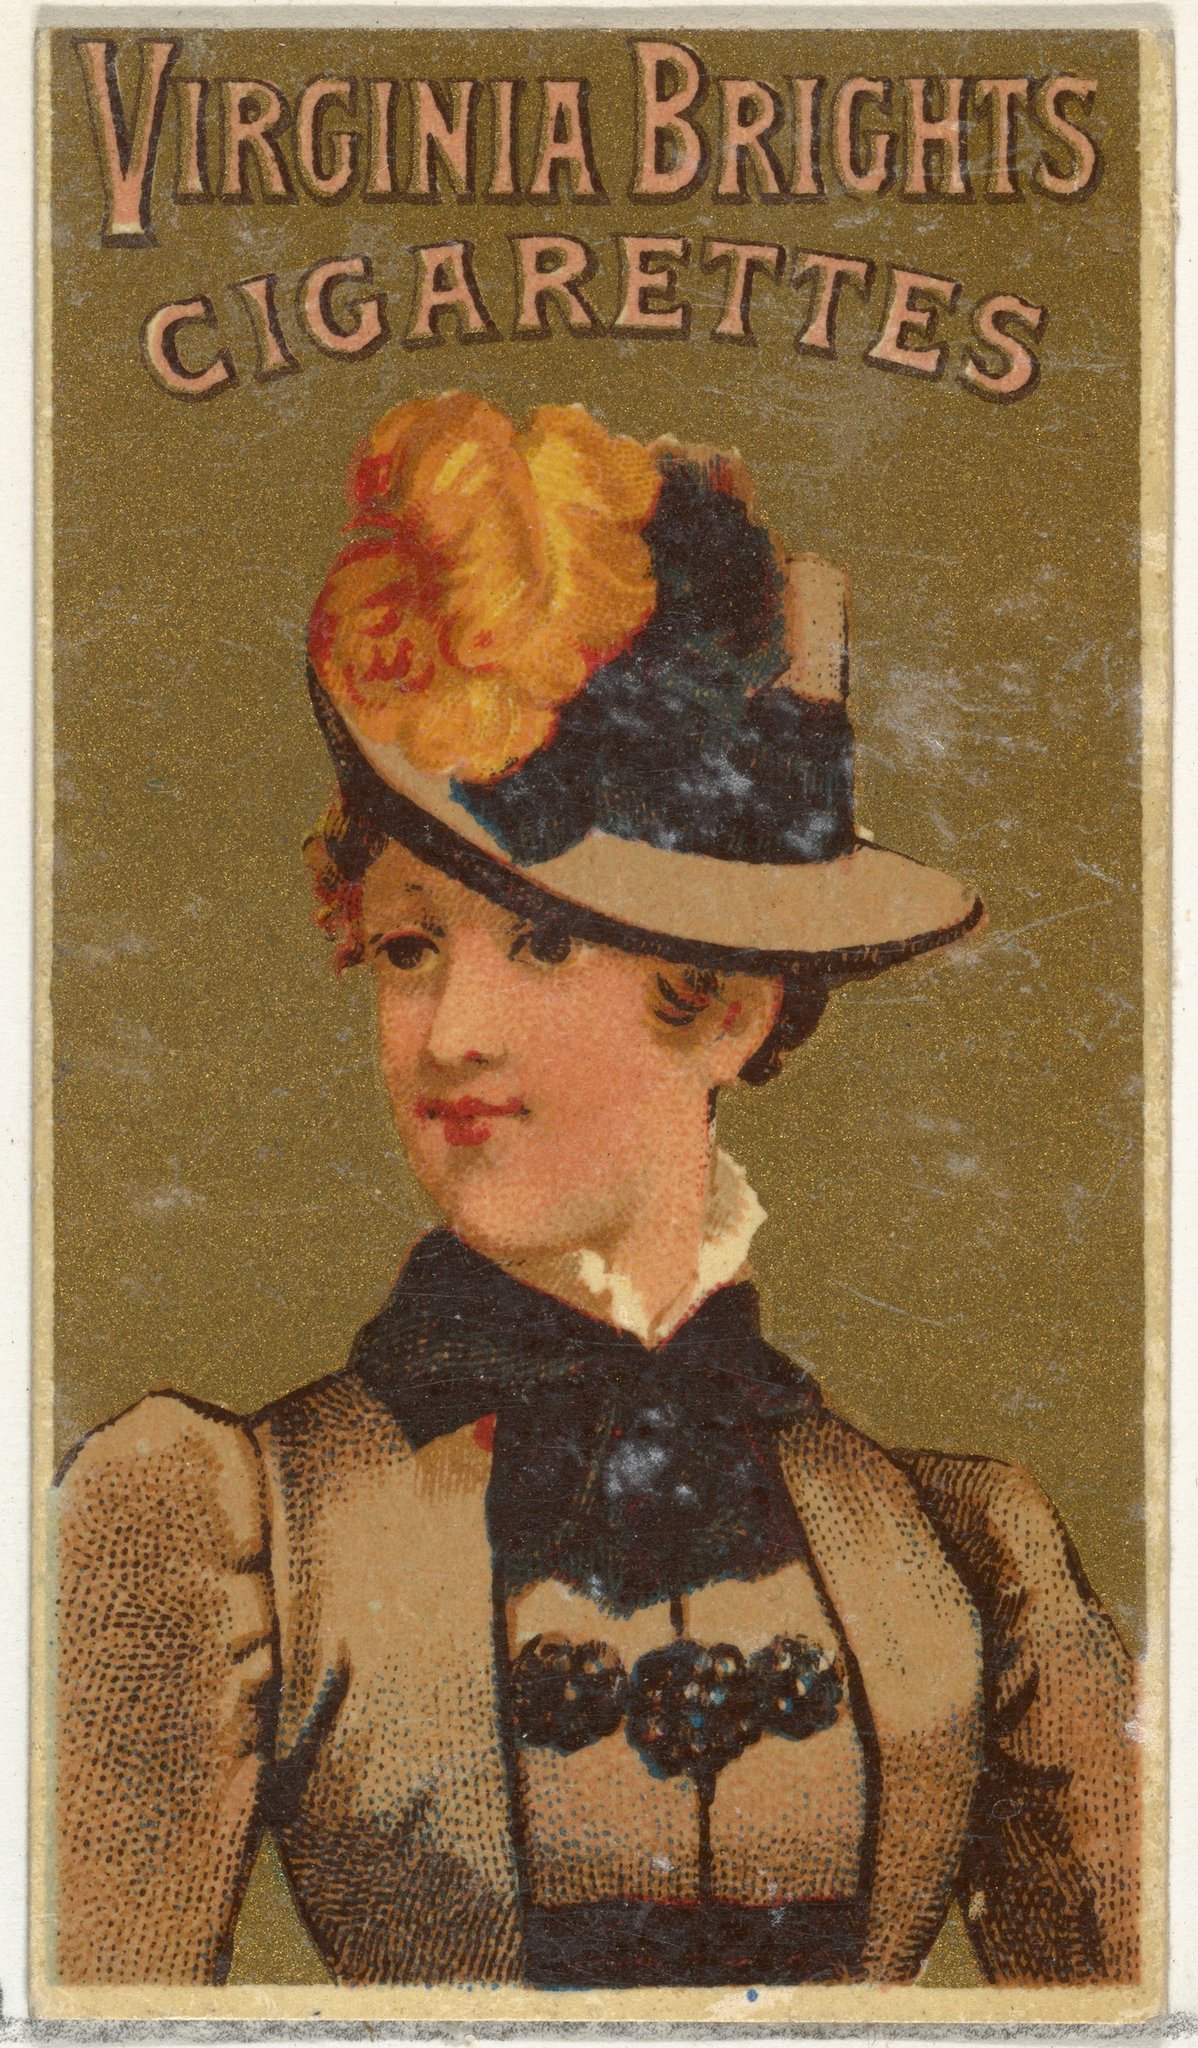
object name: print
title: From the Girls and Children series (N64) promoting Virginia Brights Cigarettes for Allen & Ginter brand tobacco products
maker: allen & ginter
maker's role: publisher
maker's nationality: american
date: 1886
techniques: color lithograph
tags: women